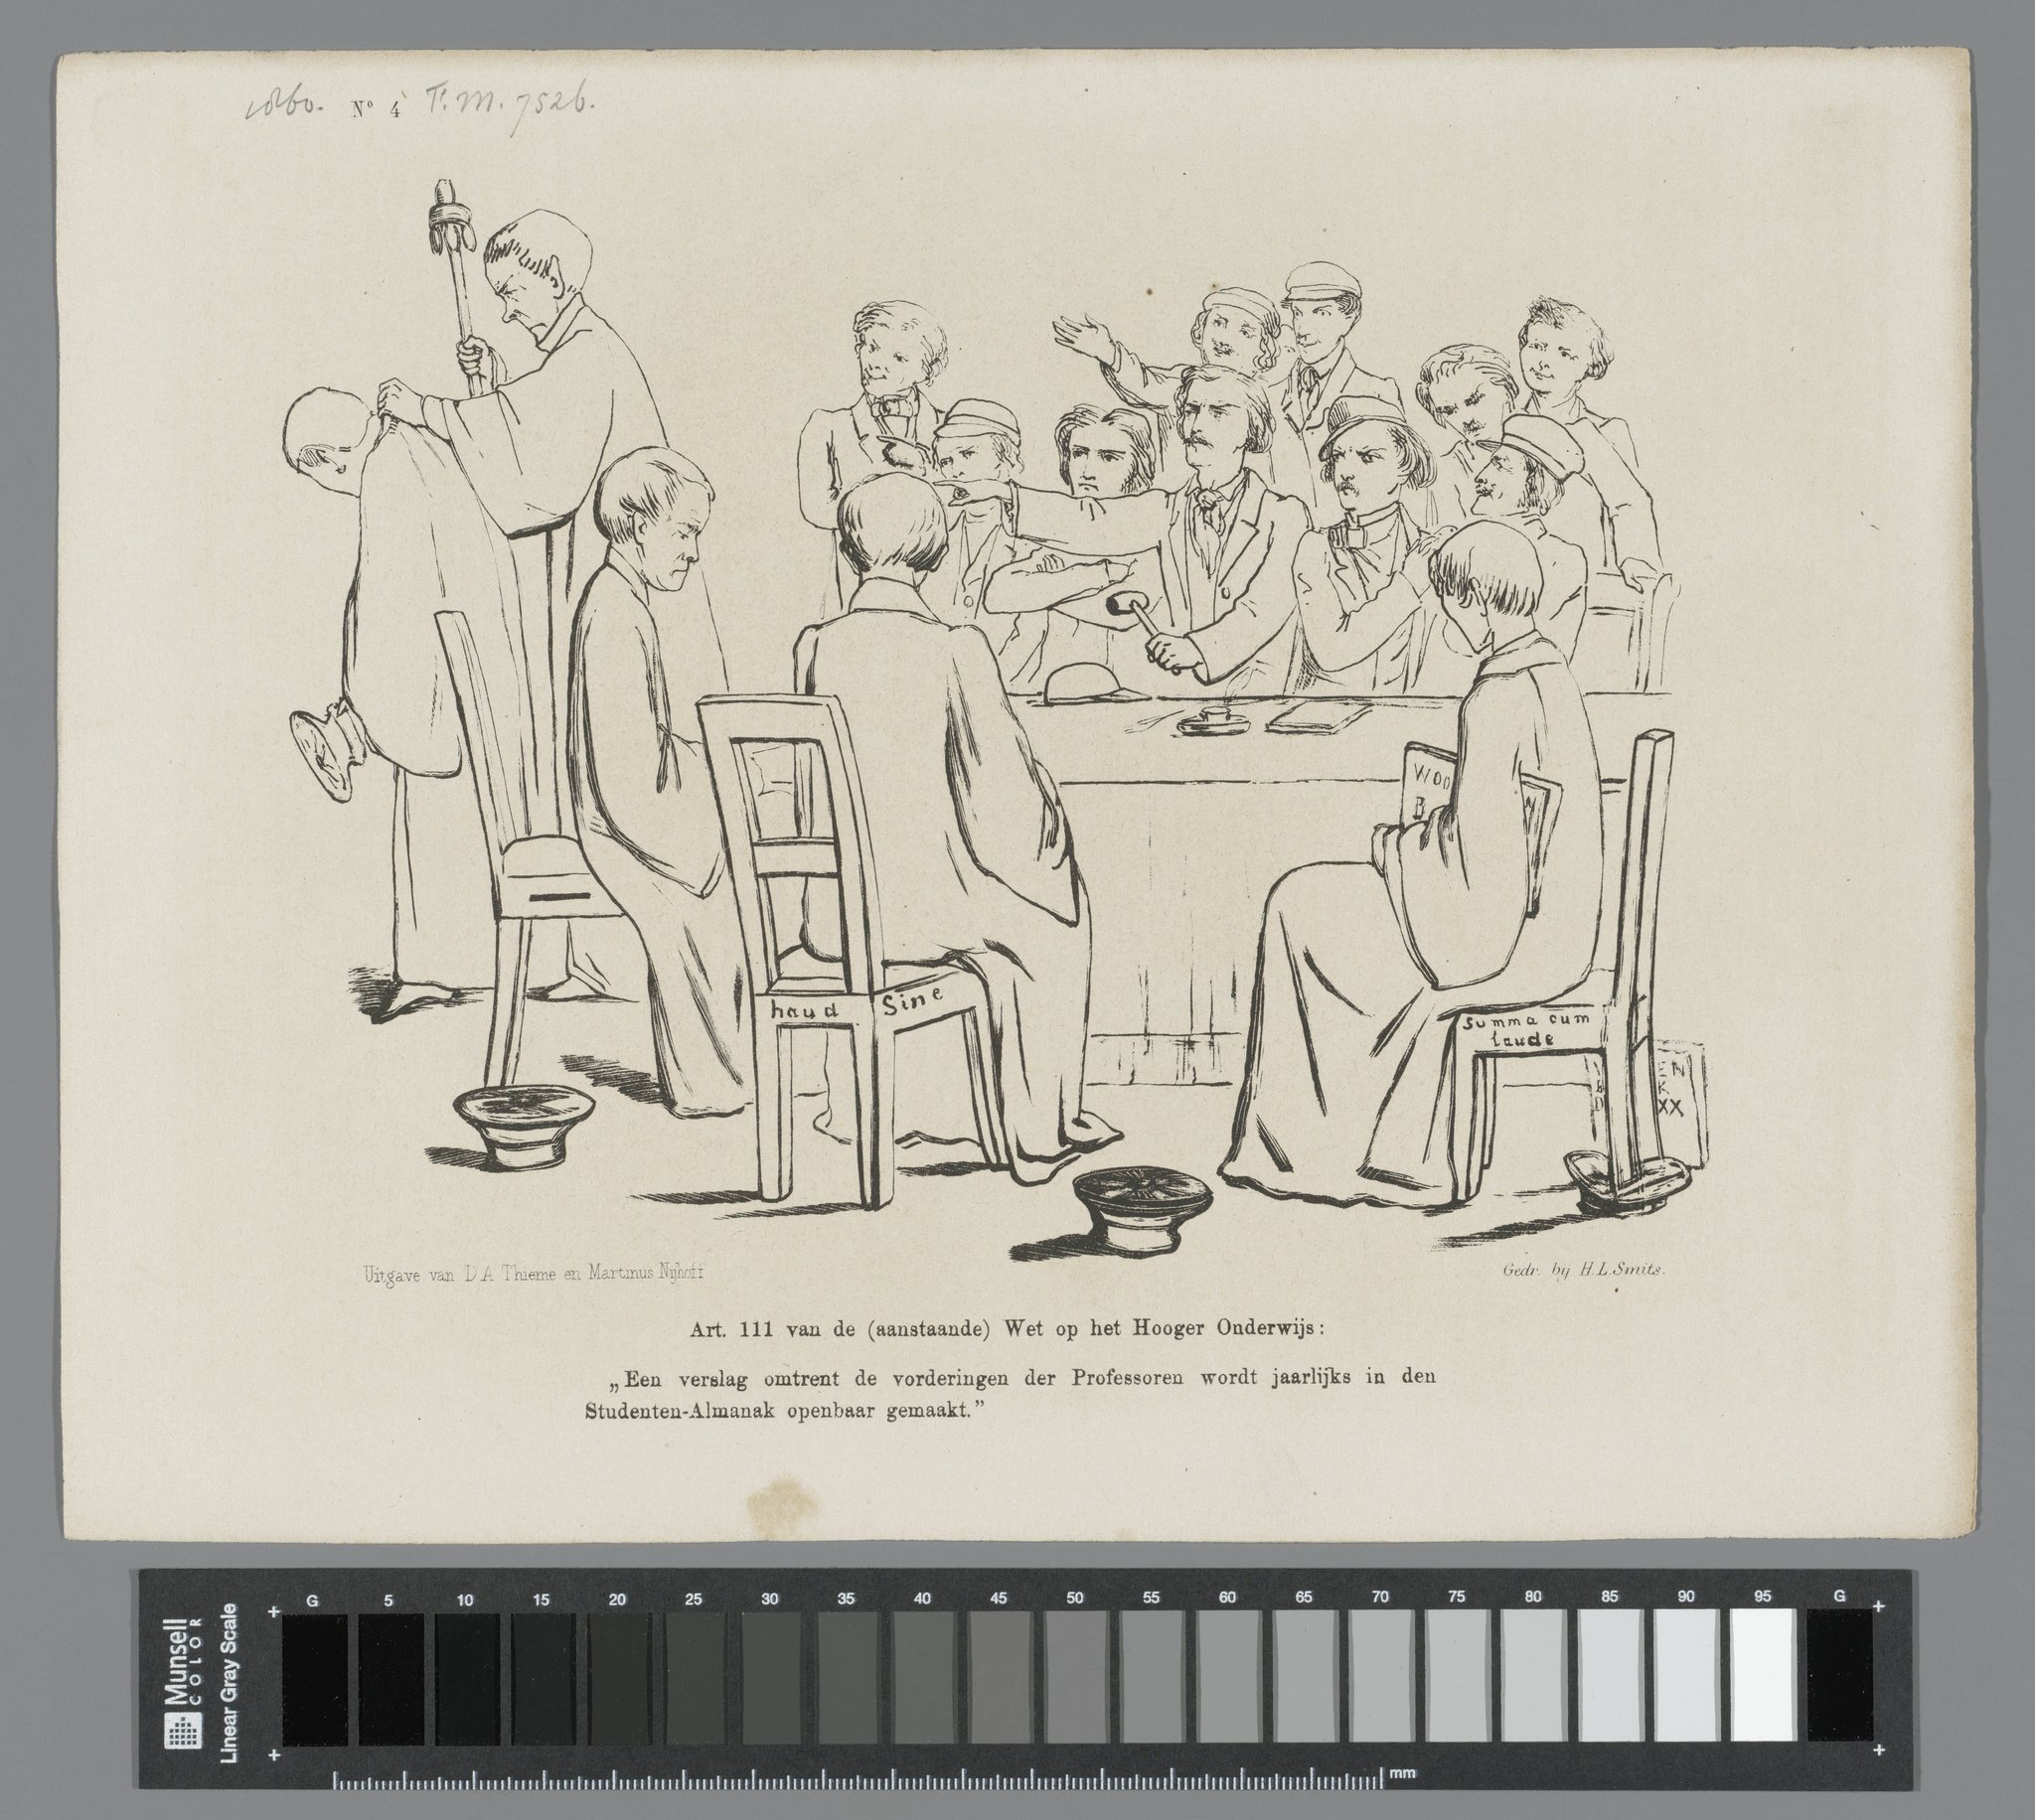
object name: cartoon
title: Spotprent op de Wet op het Hoger Onderwijs, 1860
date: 1860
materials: paper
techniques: lithograph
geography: arnhem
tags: examination ~ university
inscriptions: collector's mark: Lugt 2228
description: Spotprent op de voorgenomen Wet op het Hoger Onderwijs. Een groep studenten examineert de professoren. Plaat verschenen bij het weekblad De Nederlandsche Spectator, nr. 4, 28 januari 1860.